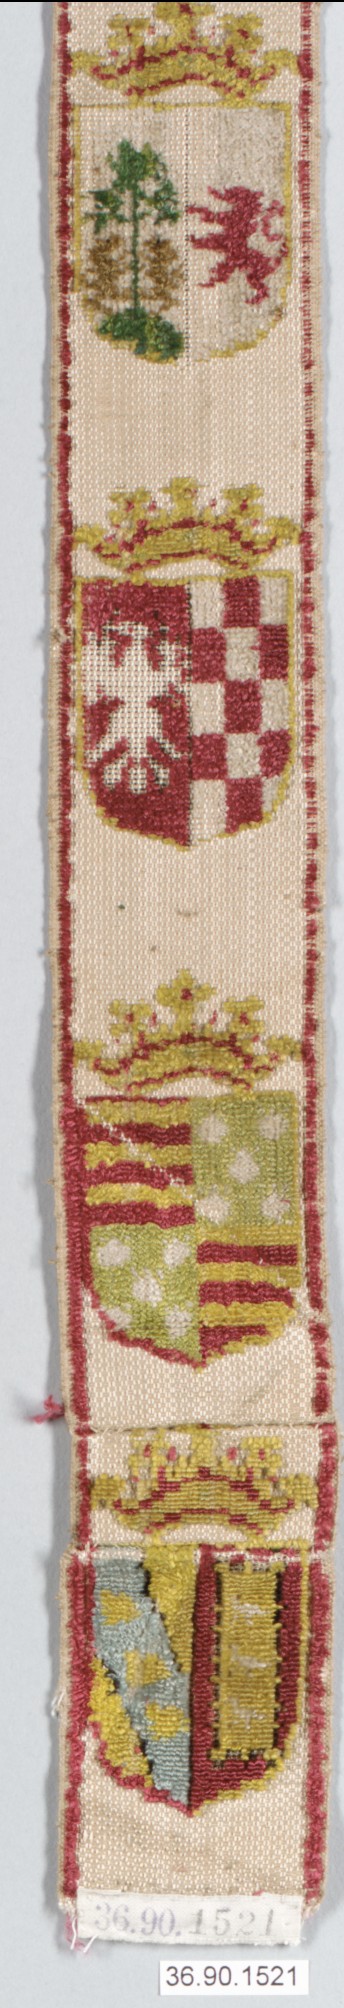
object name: galloon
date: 1701-1900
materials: silk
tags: coat of arms